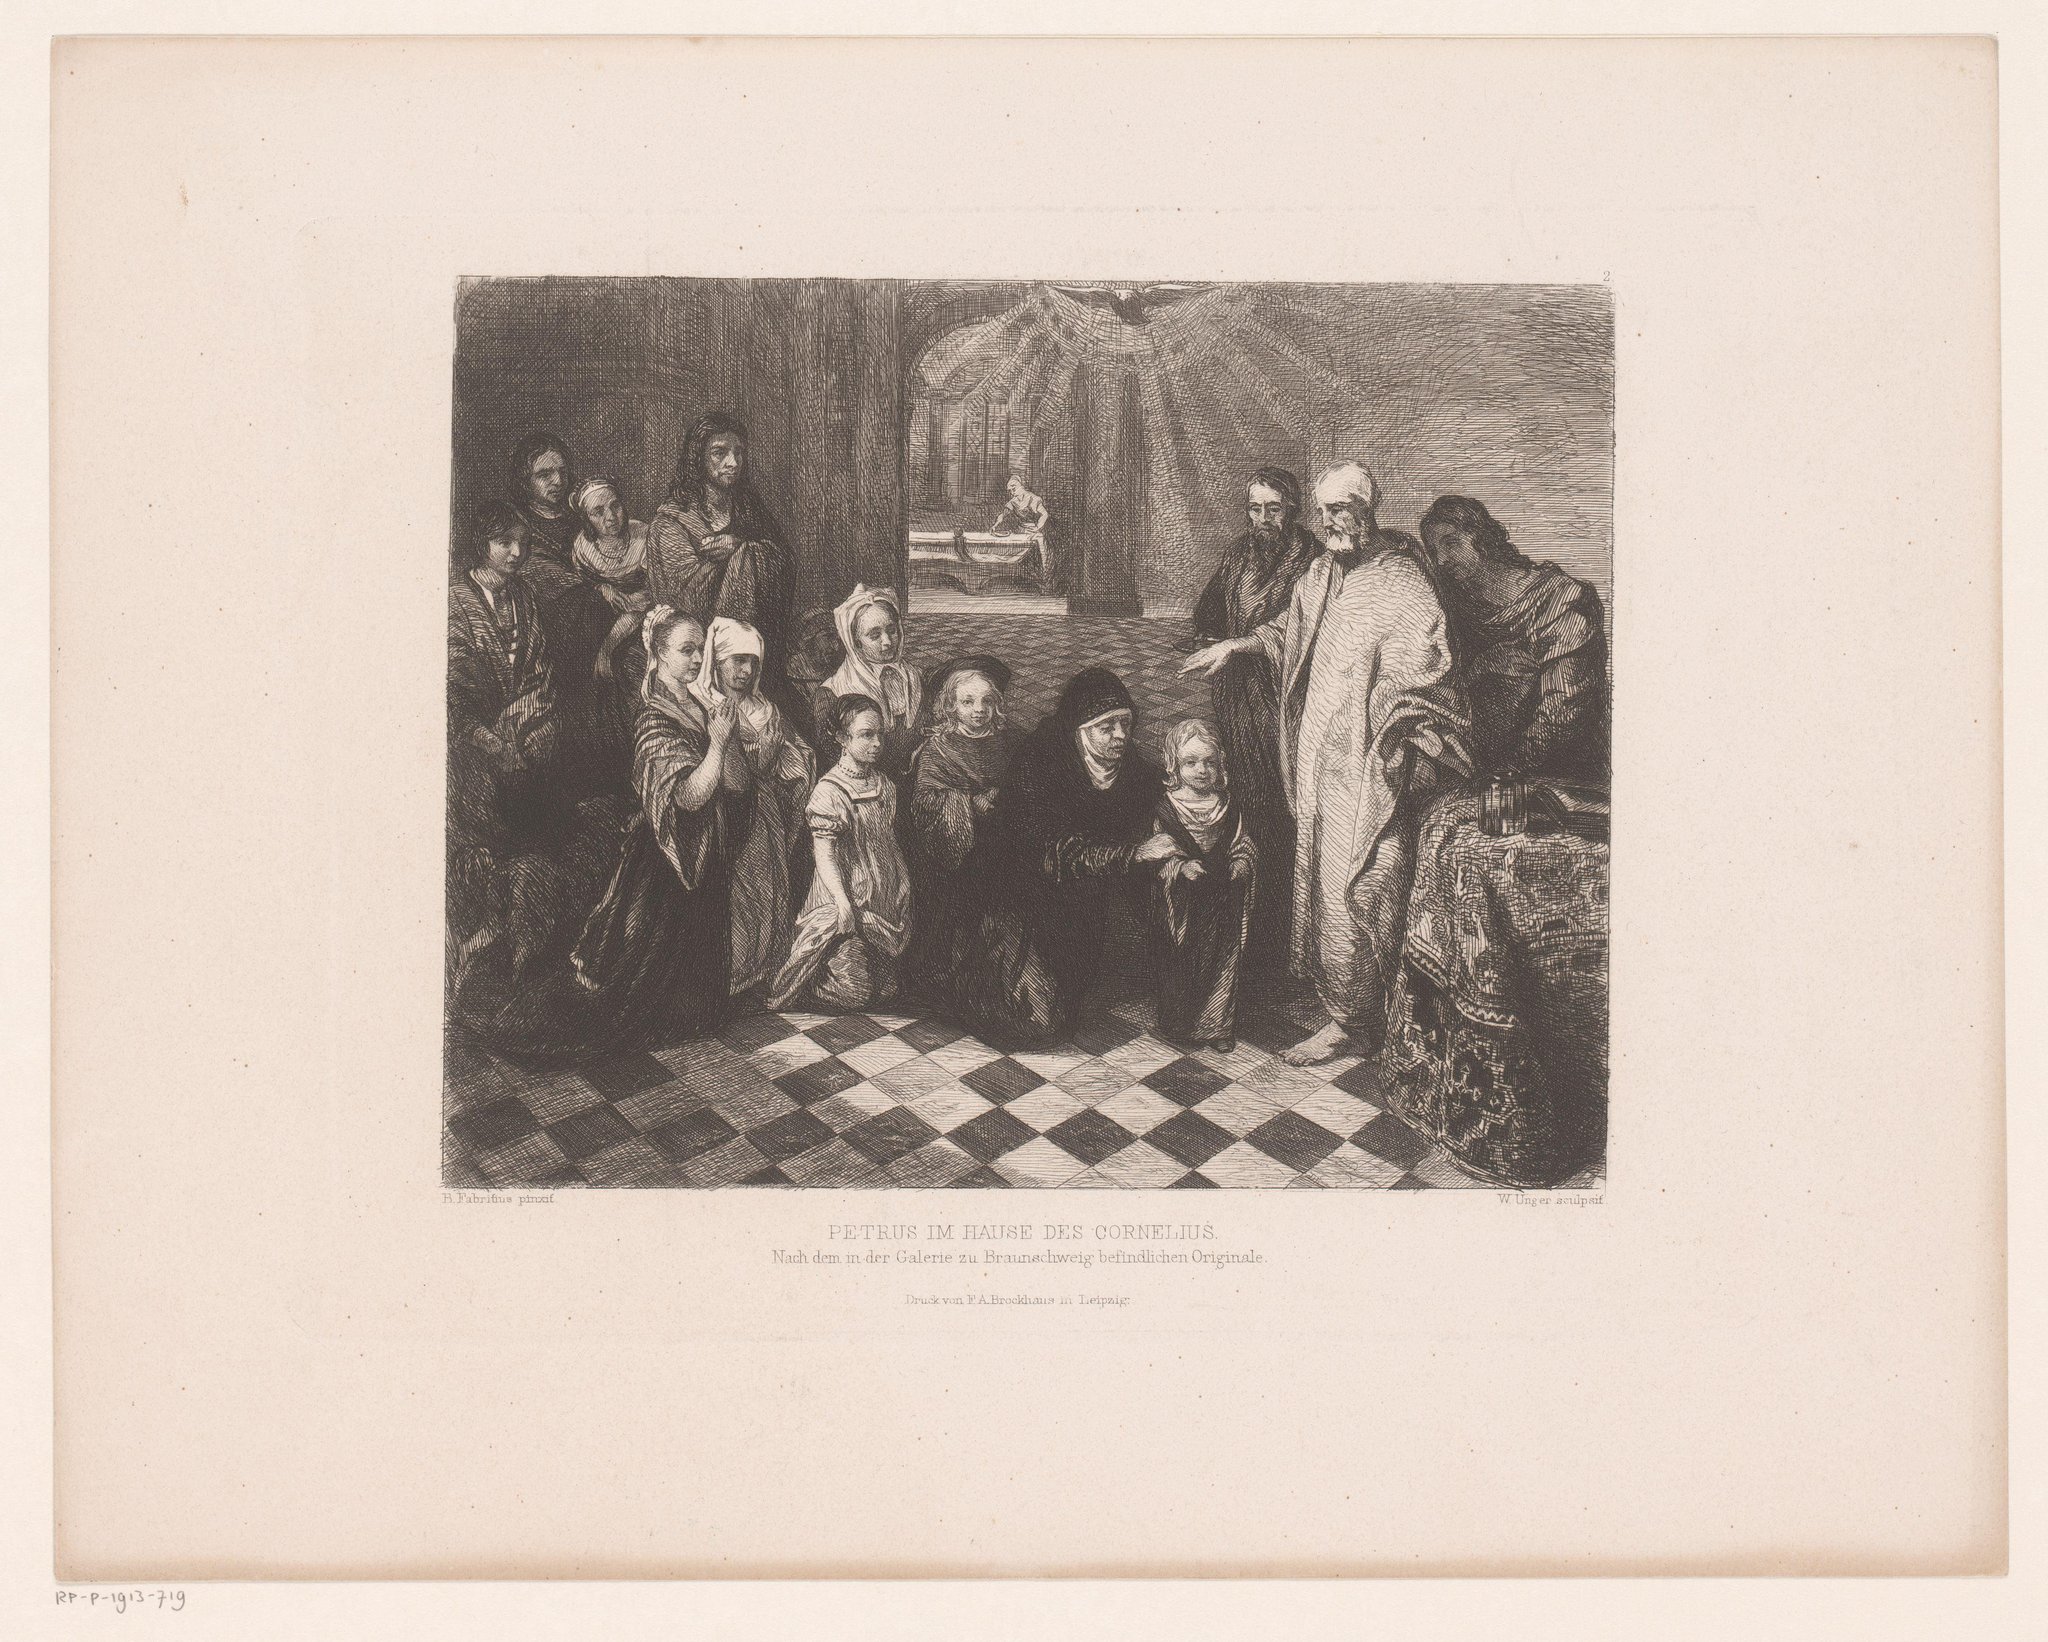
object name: print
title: Petrus im Hause des Cornelis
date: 1847-1889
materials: paper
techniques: etching, intaglio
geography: germany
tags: peter in the house of cornelius: the holy ghost descends upon cornelius and his family, who are baptized by peter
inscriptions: collector's mark: Lugt 2233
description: Prent naar het schilderij door Barent Fabritius in het Herzog Anton Ulrich-Museum te Braunschweig (inv.nr. 268).